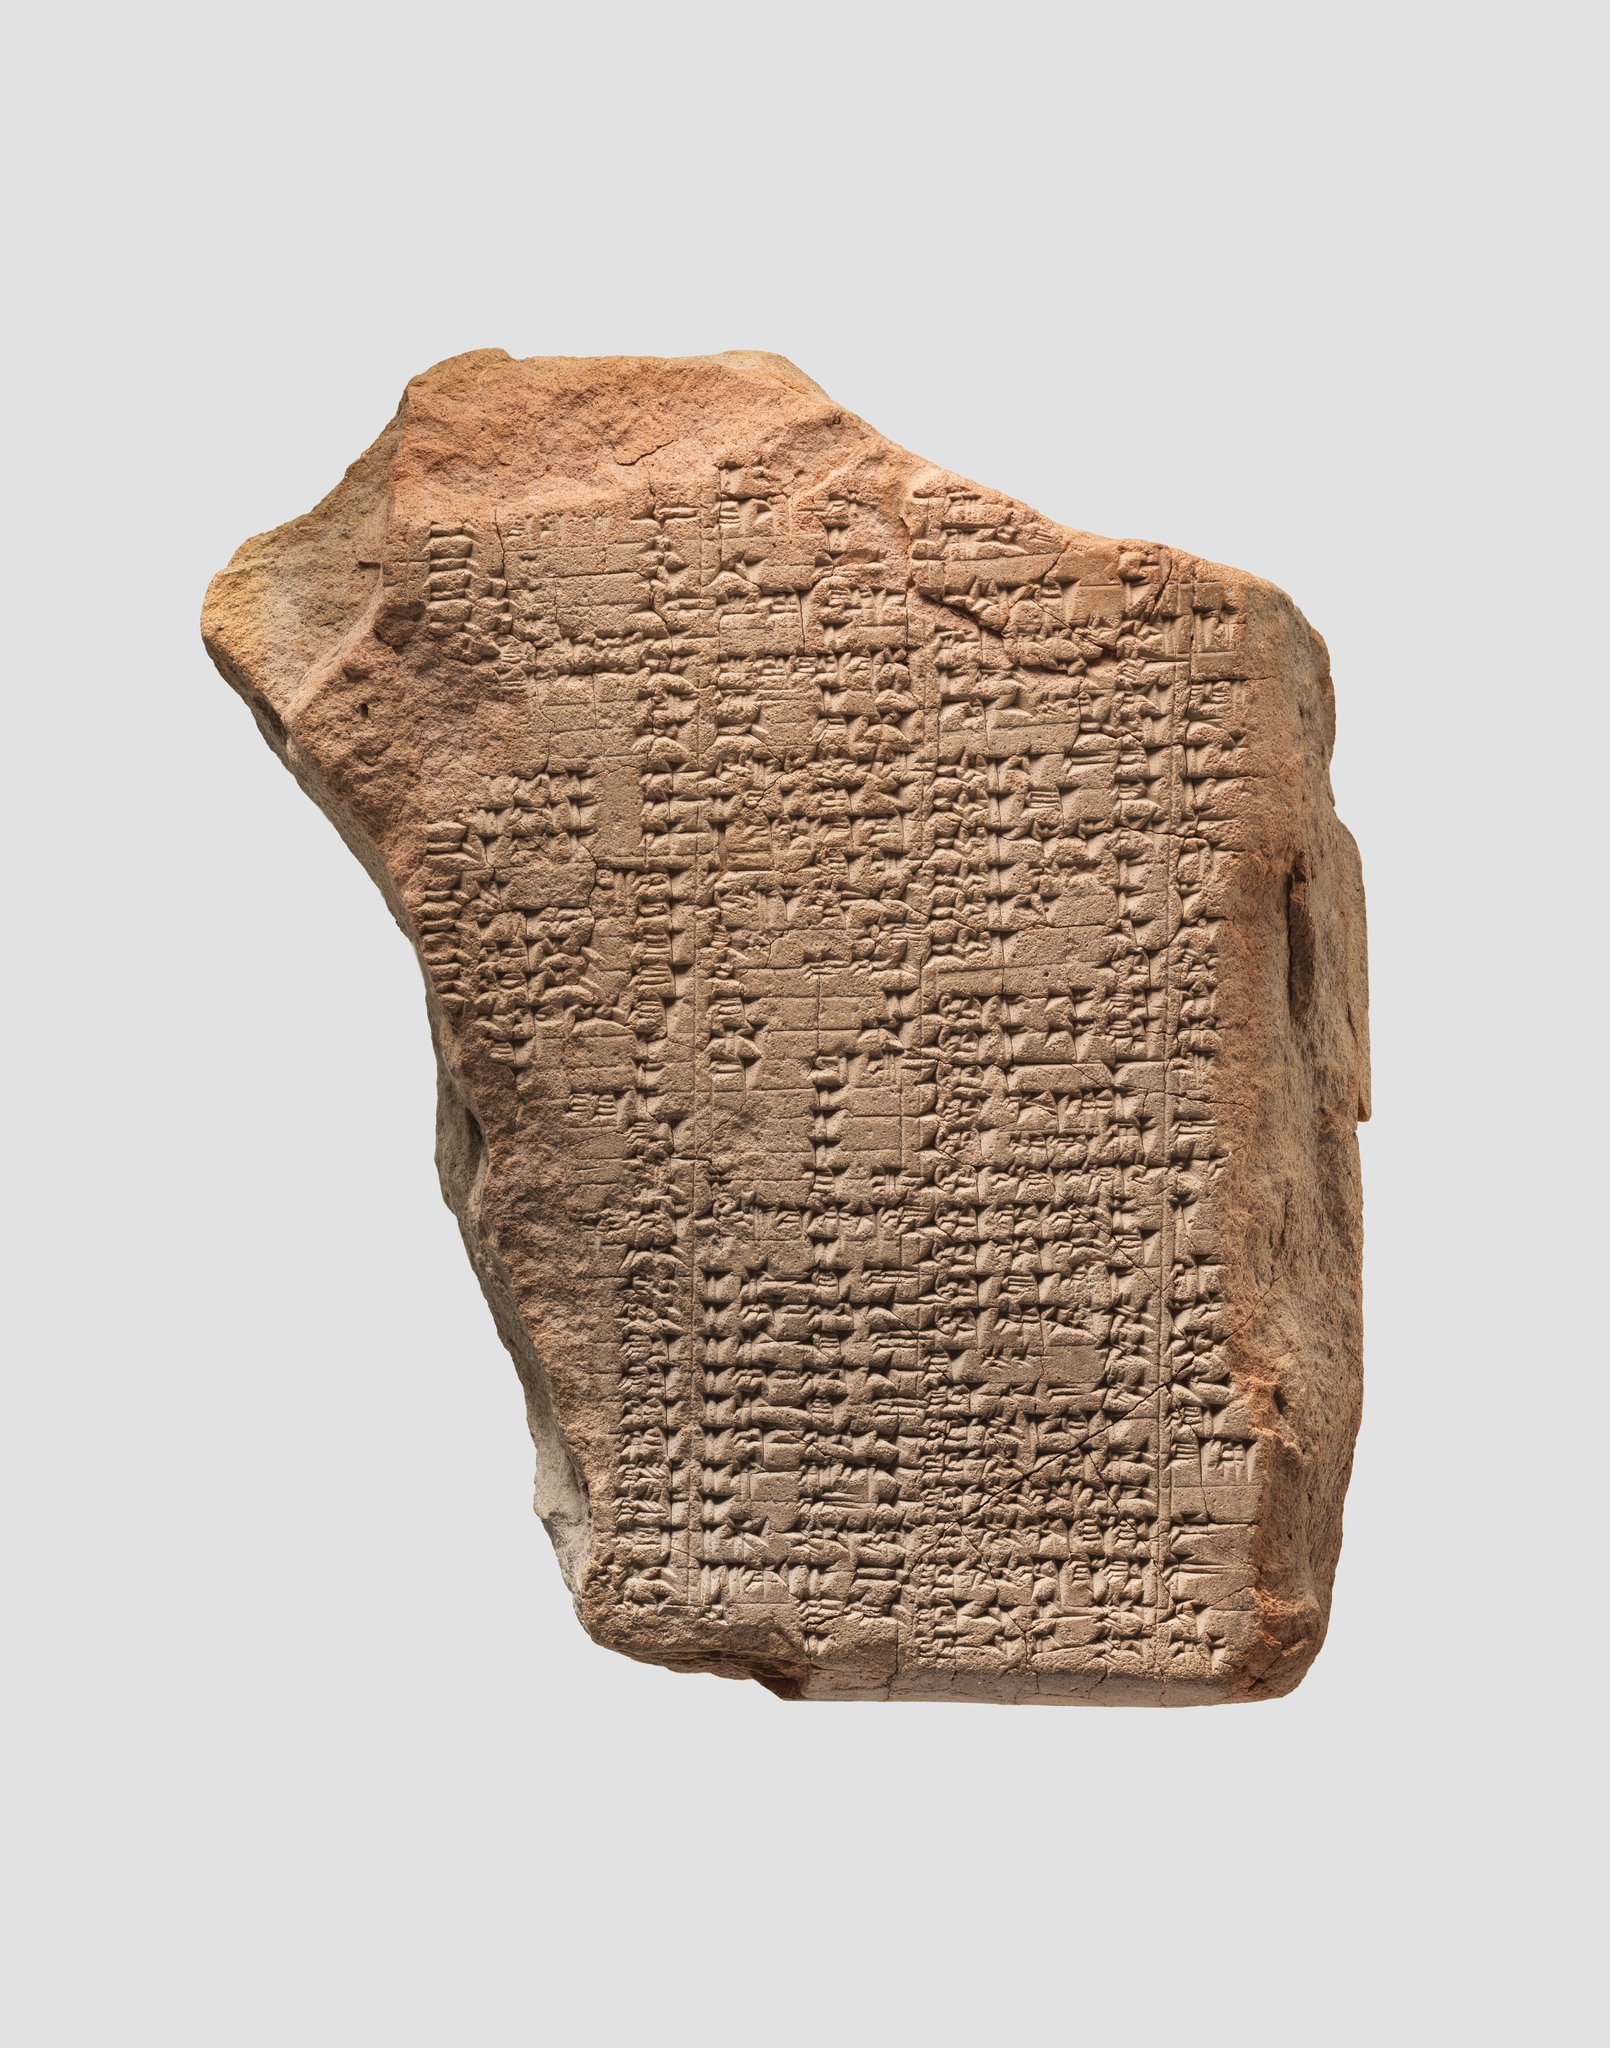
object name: cuneiform tablet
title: Cuneiform tablet: vocabulary of food and drink terms, Urra=hubullu, tablet 23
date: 333-1 BCE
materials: clay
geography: mesopotamia